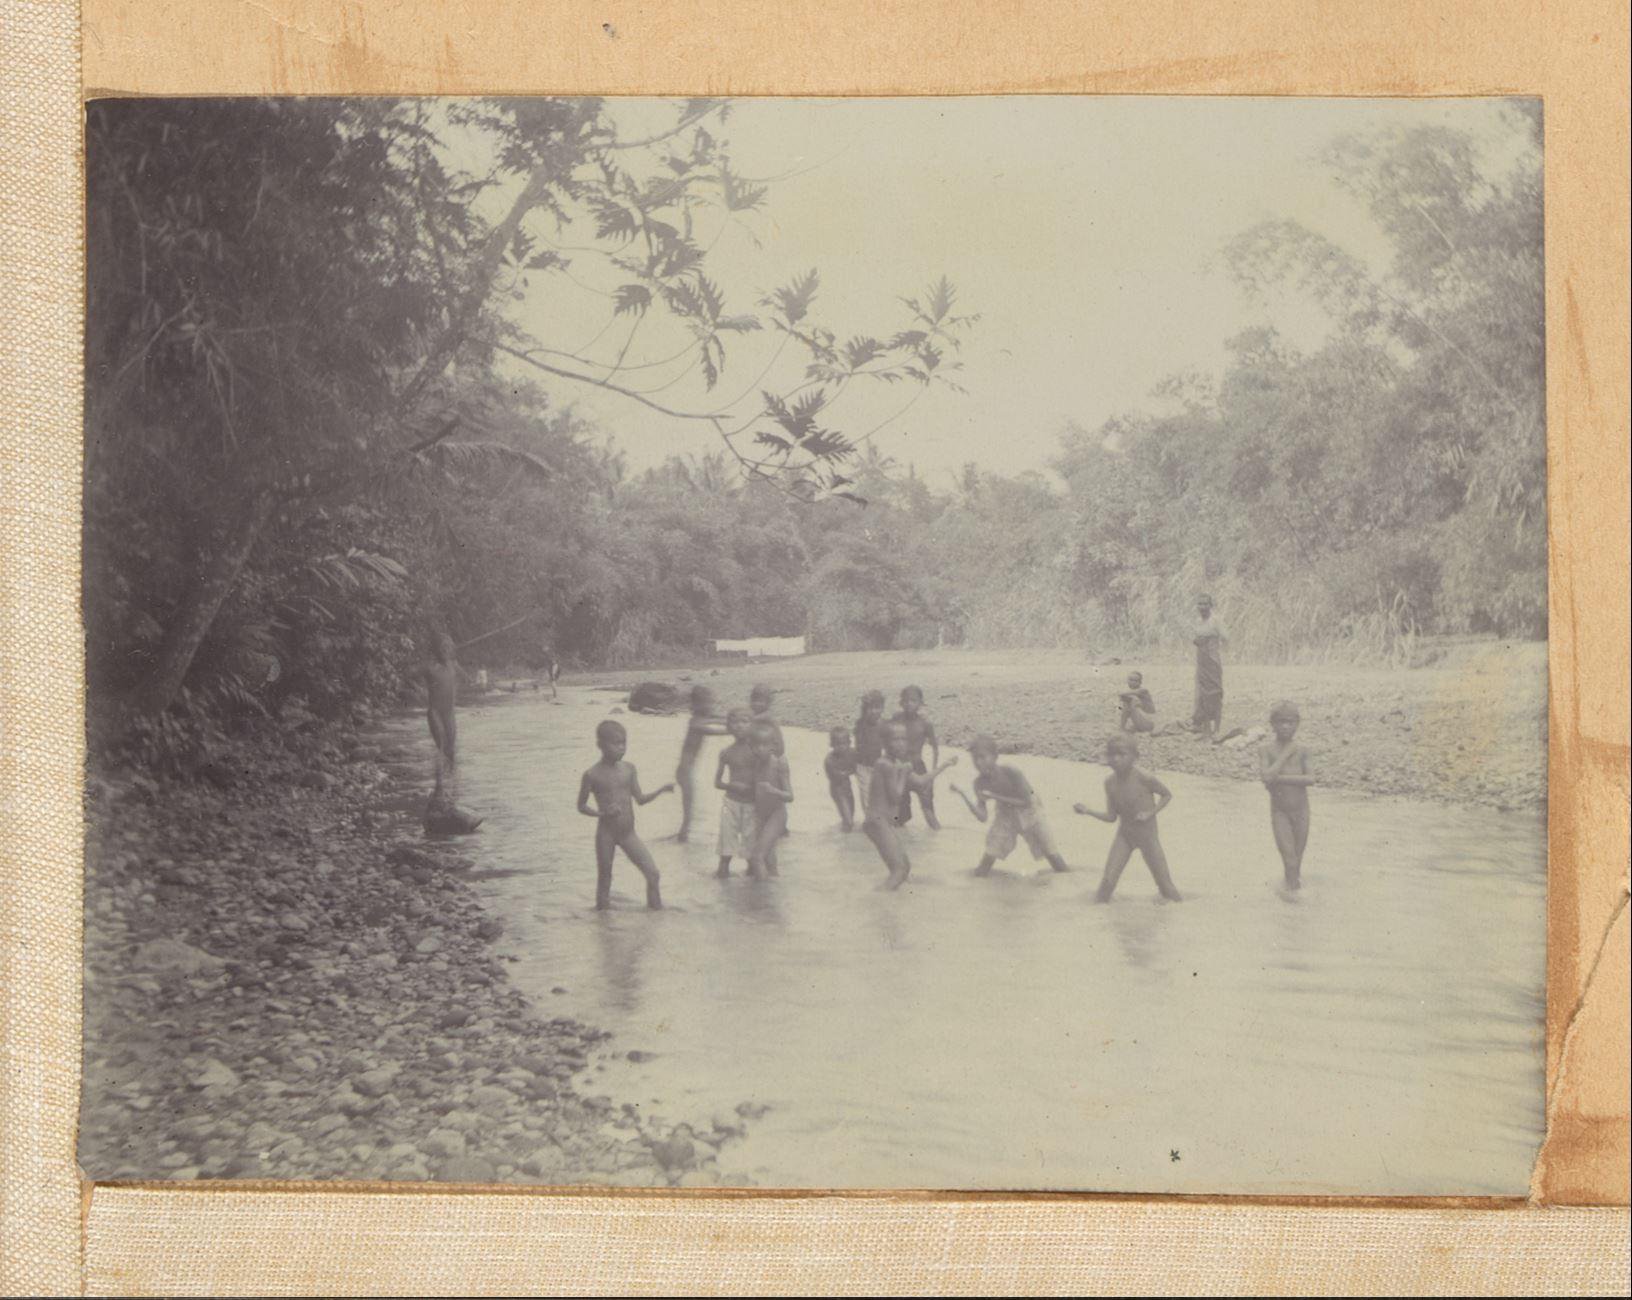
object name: photograph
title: Kinderen spelend in een rivier in Nederlands-Indië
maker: Anonymous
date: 1917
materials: photographic support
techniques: gelatin silver print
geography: dutch east indies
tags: child, swimming (movement in water), river (+ landscape with figures, staffage), dutch east indies, the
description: Onderdeel van Familiealbum met foto's van een familie in de voormalige kolonie Nederlands-Indië en van een suikerfabriek in Purworejo.